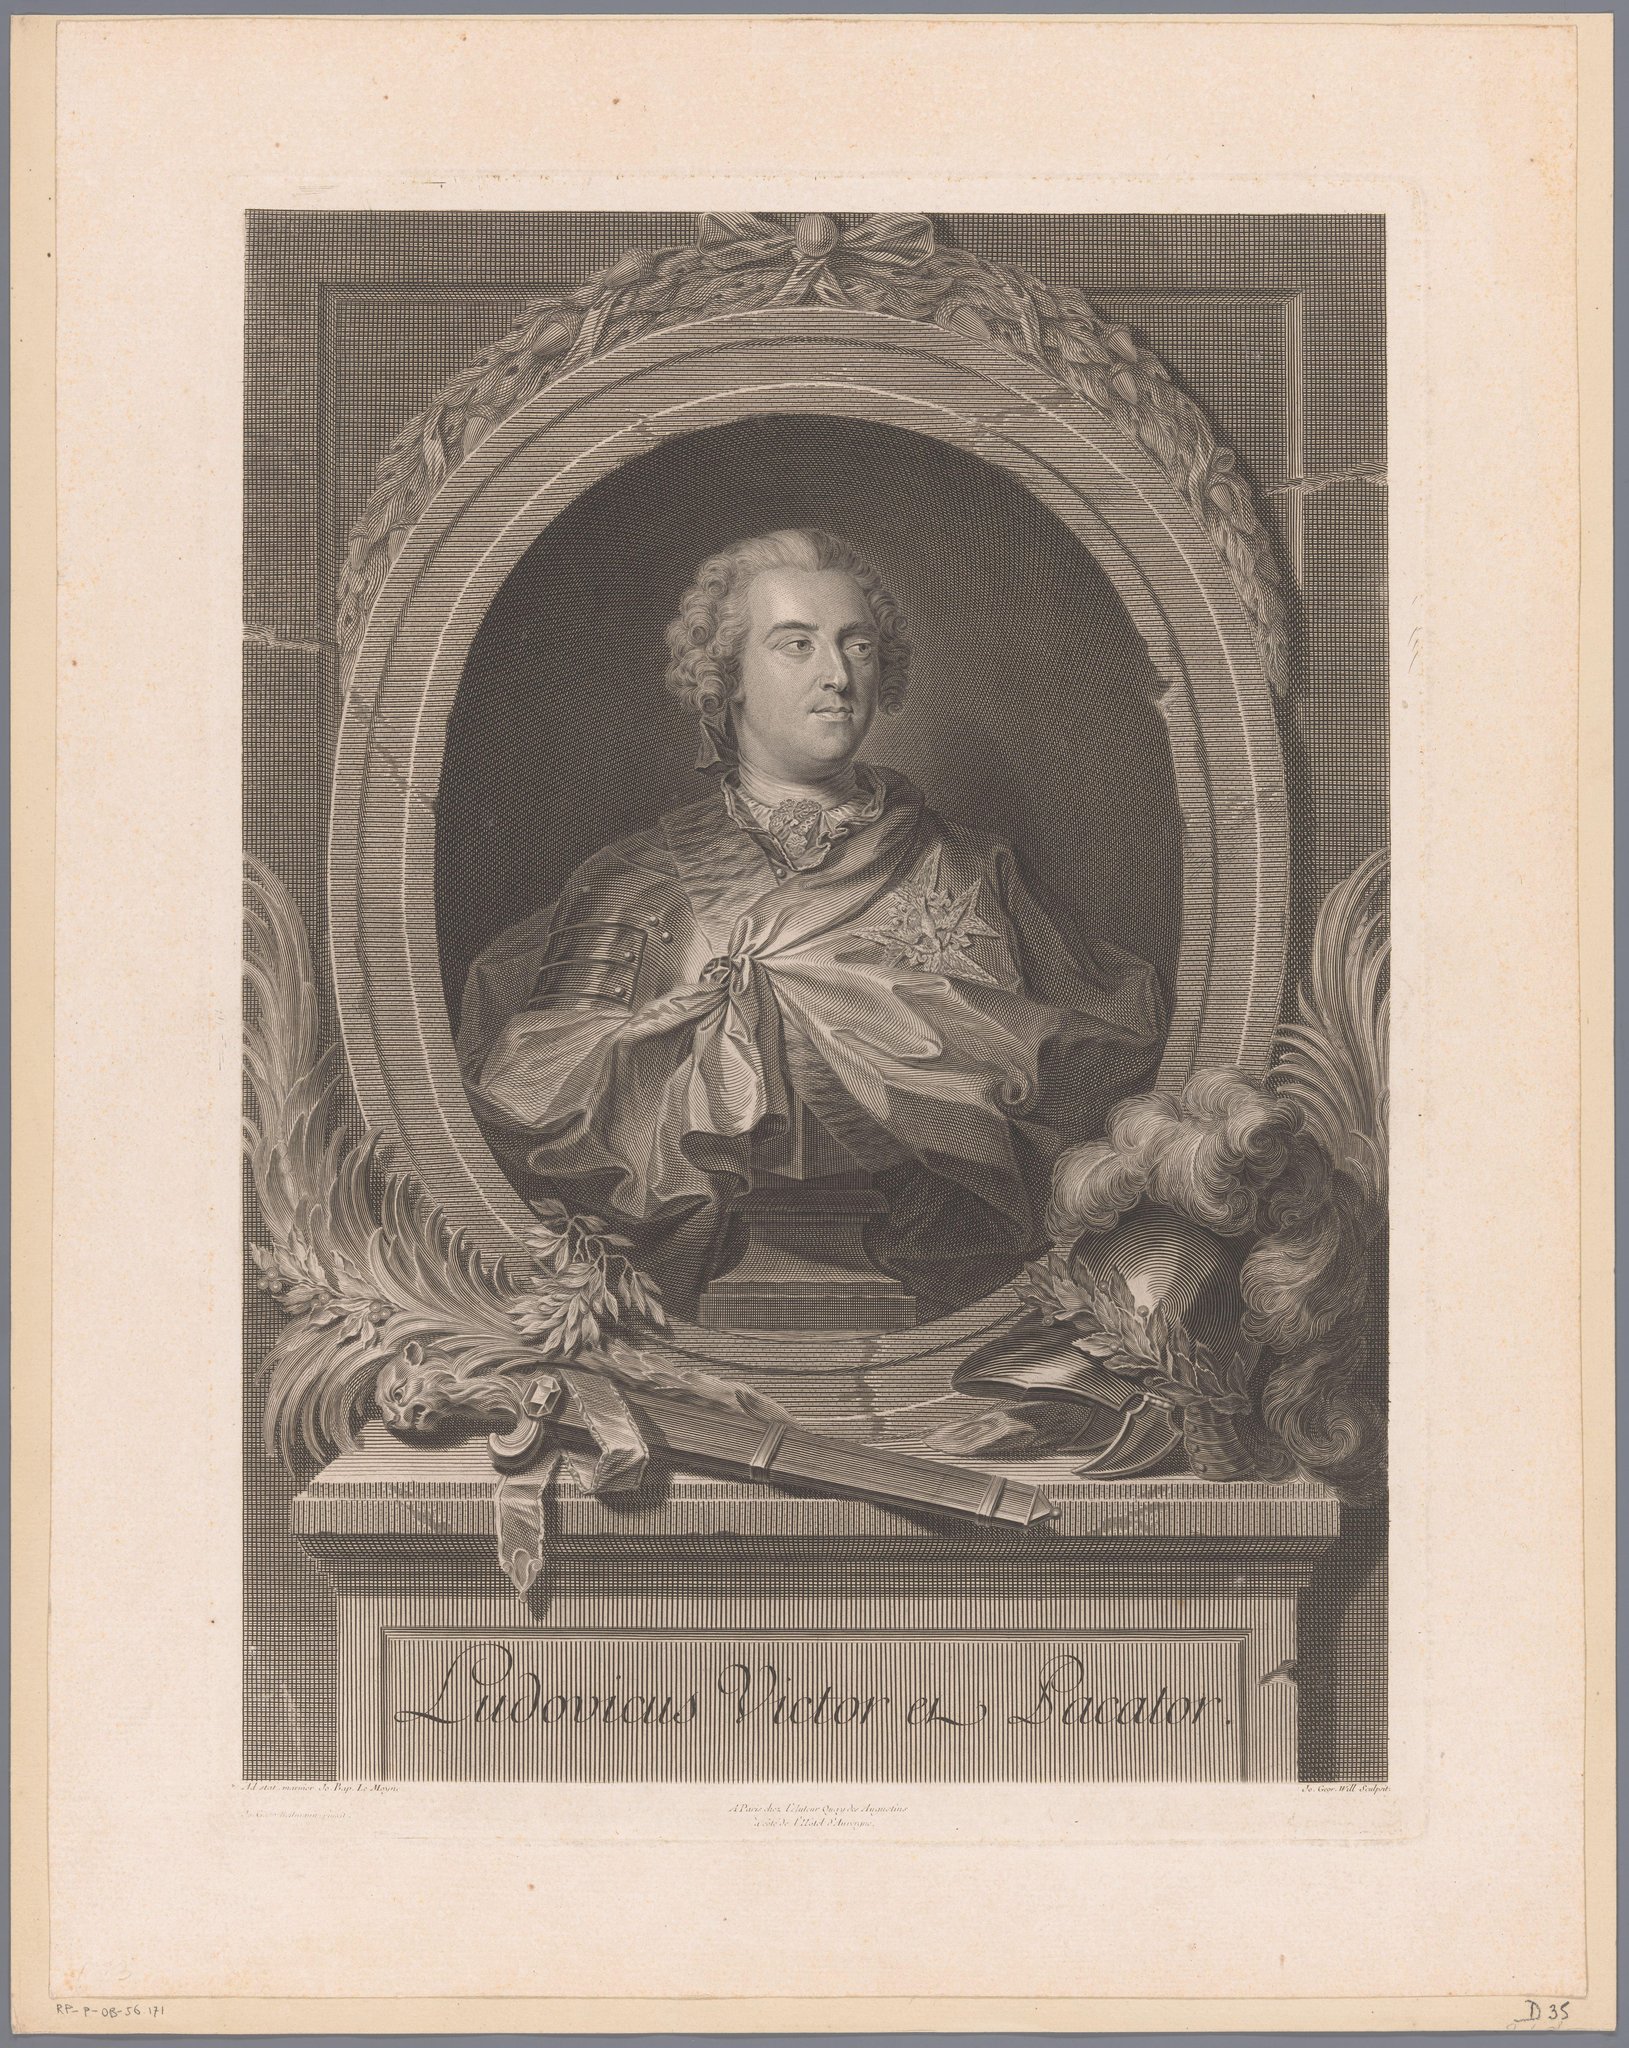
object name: print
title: Portret van Lodewijk XV, koning van Frankrijk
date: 1738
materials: paper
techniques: engraving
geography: france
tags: louis xv of france, historical persons